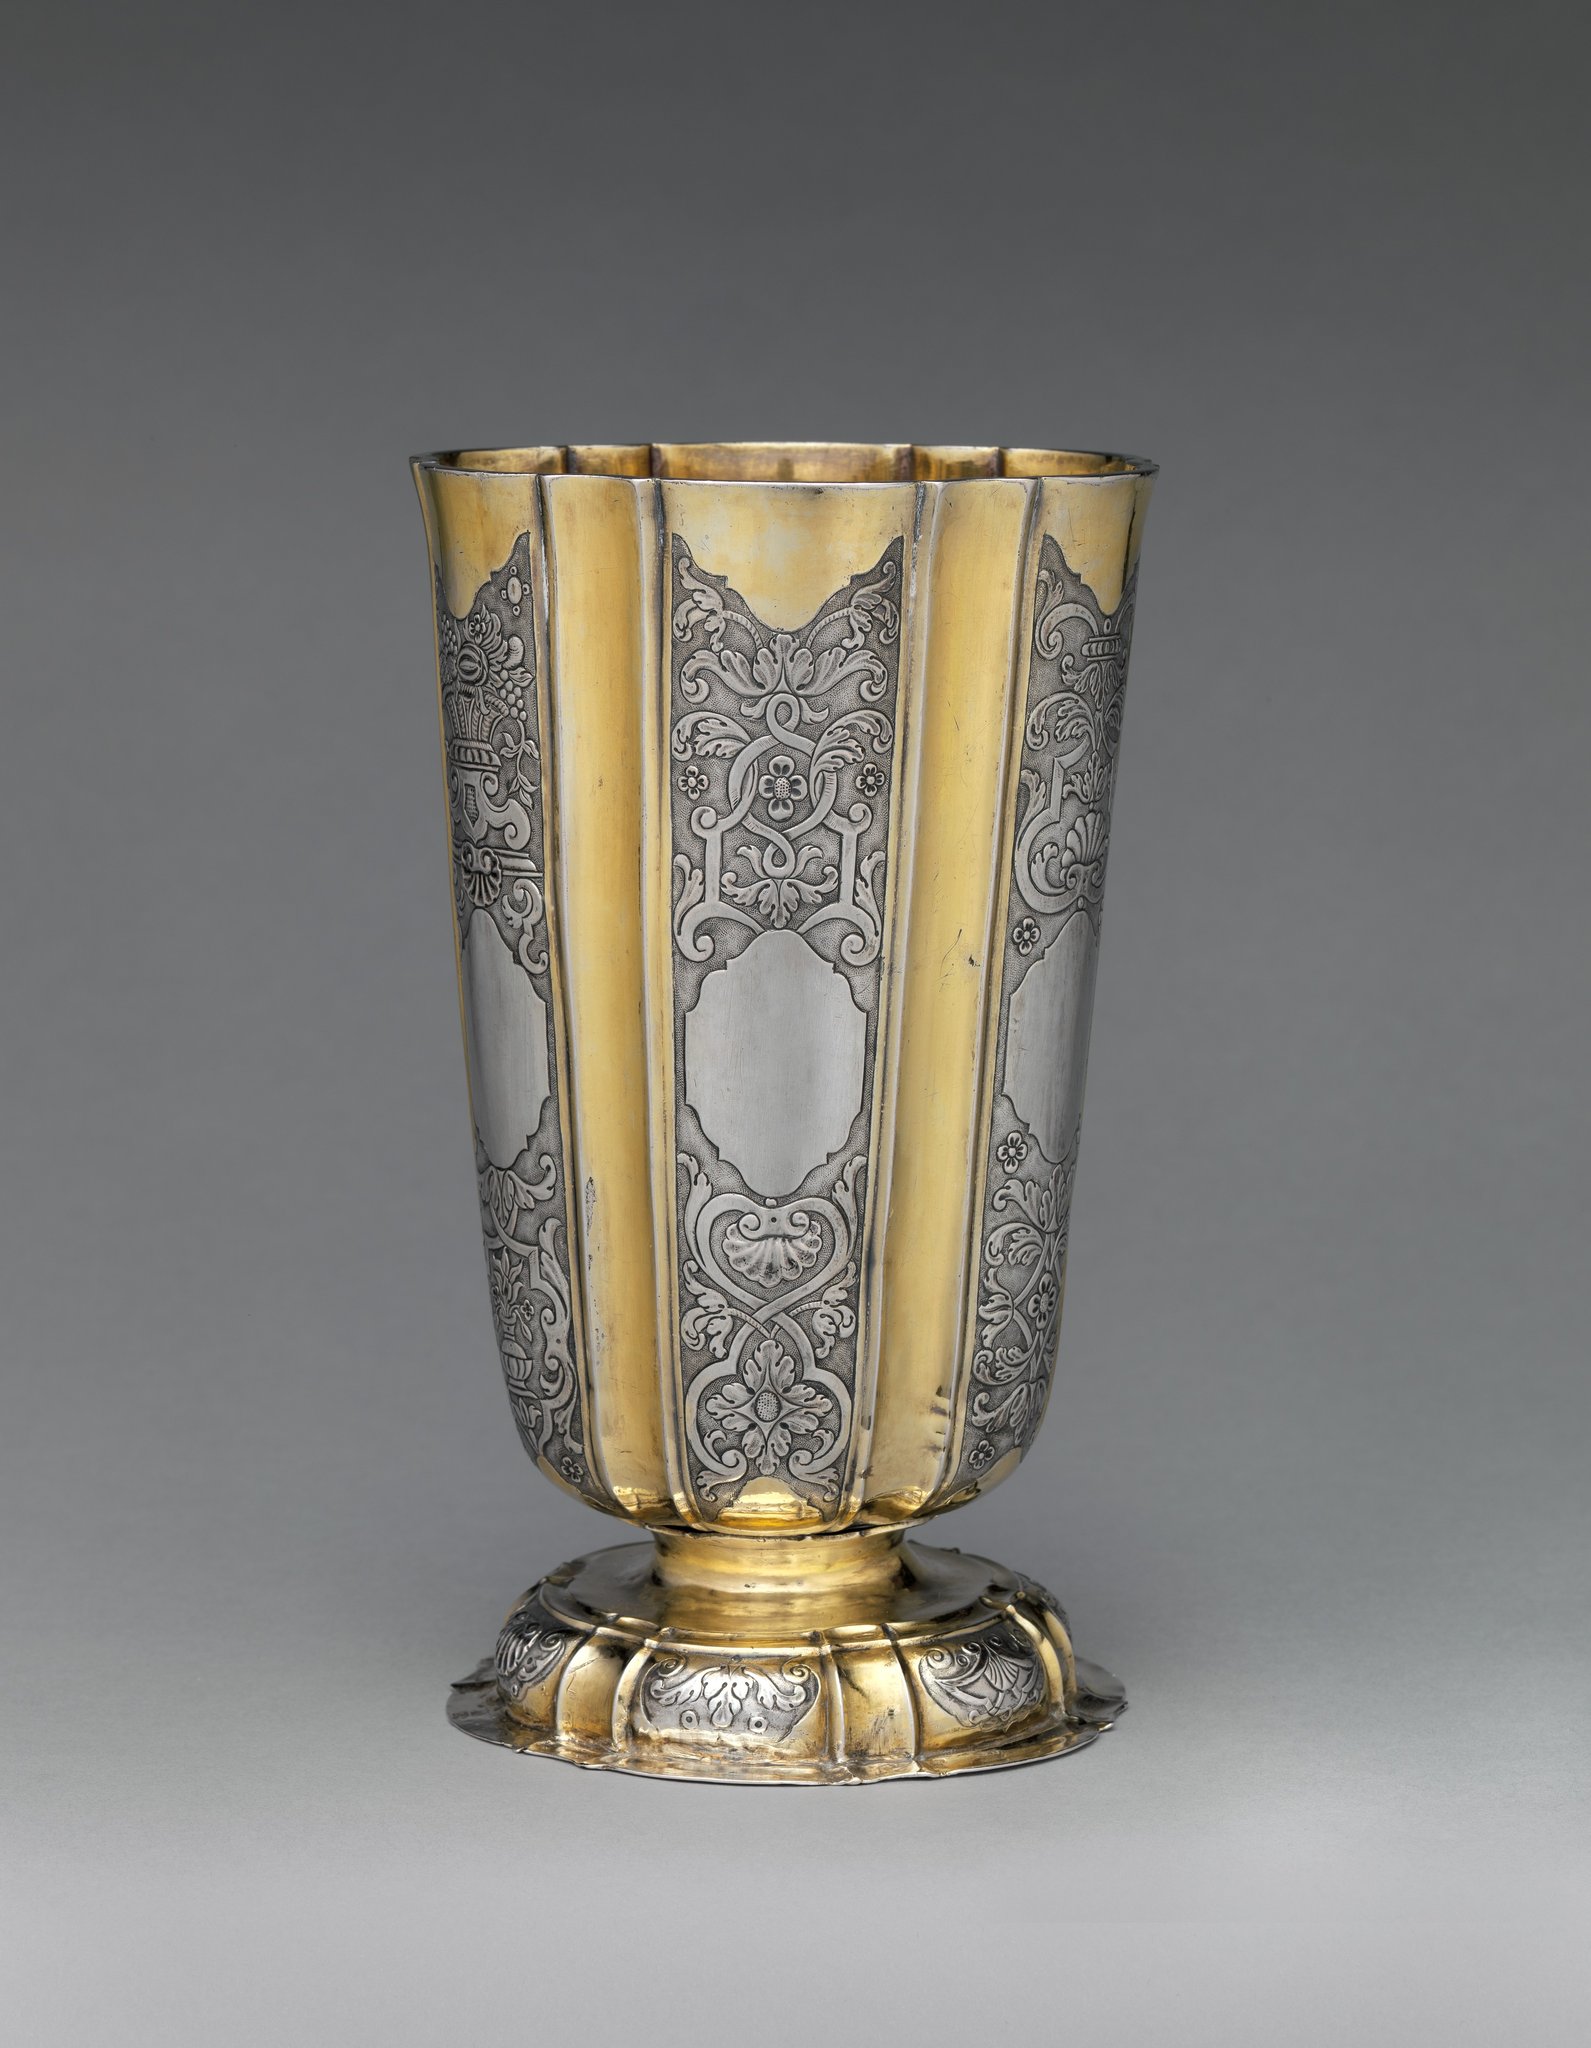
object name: beaker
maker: georgius olescher jr.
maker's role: maker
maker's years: 1661-1761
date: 1730-1750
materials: silver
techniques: gilding